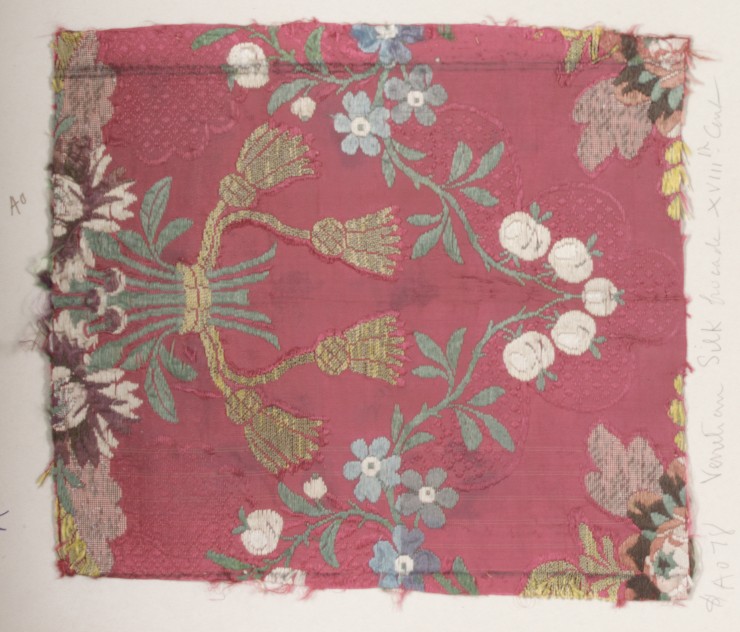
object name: fragment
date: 1701-1800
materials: metal thread, silk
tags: flowers,plants